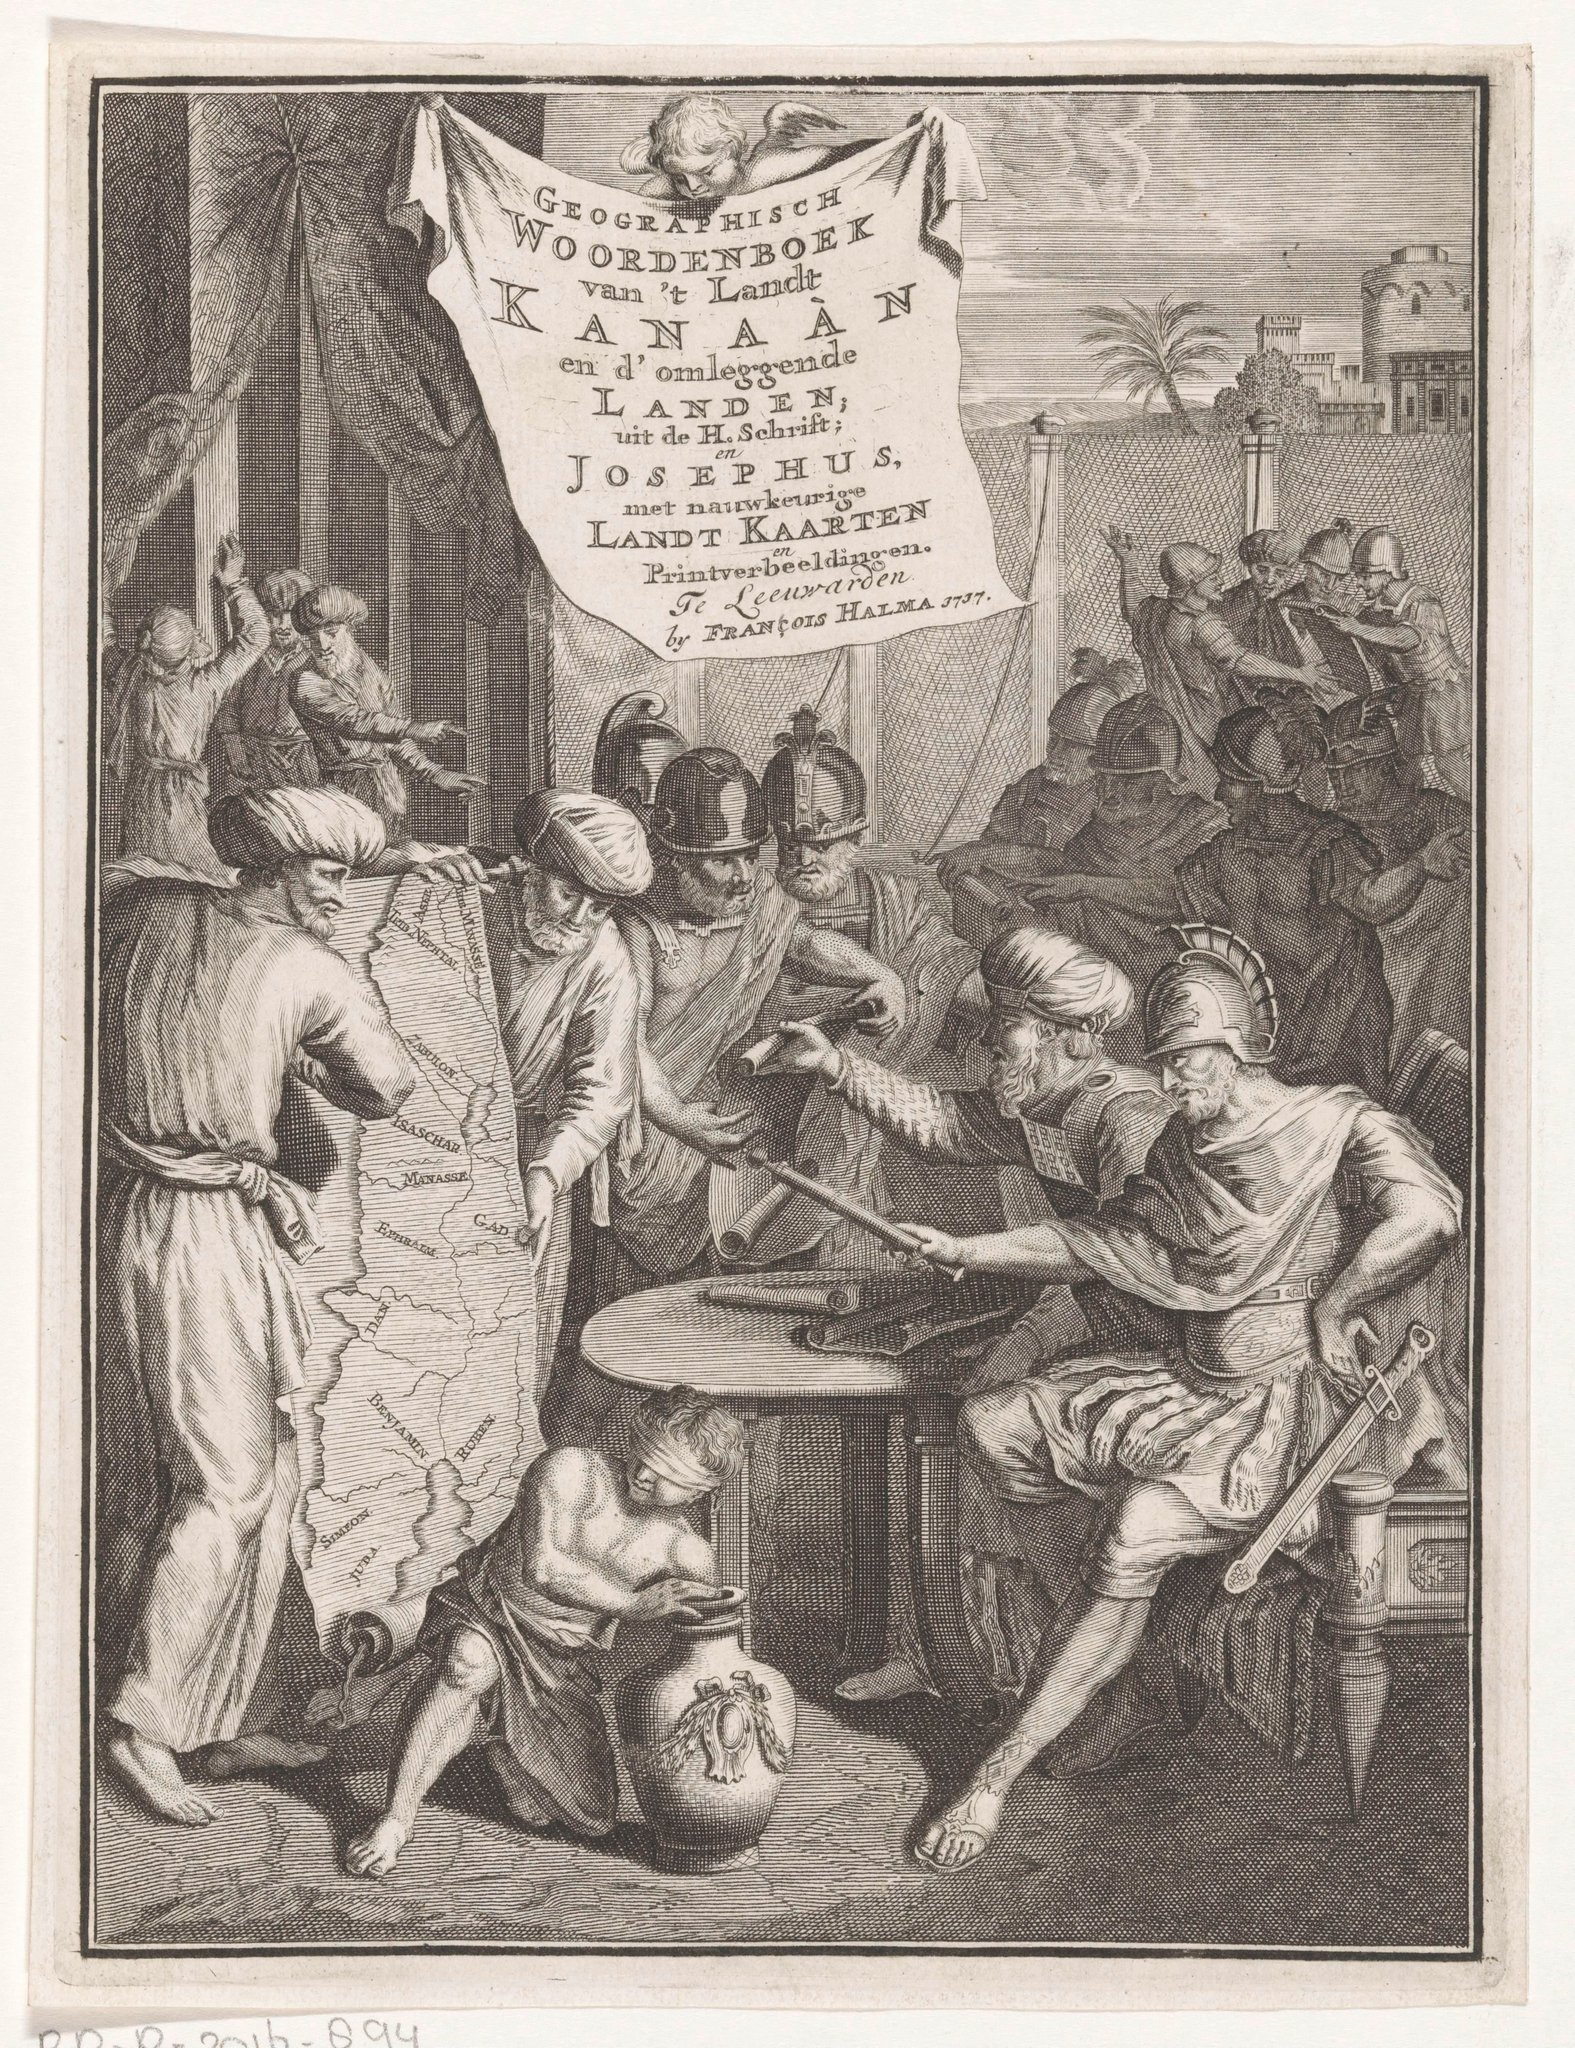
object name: print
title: Mannen bekijken kaart van Kanaän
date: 1717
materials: paper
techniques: engraving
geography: leeuwarden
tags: maps of separate countries or regions, head-gear: turban, the soldier; the soldier's life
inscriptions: collector's mark: Lugt 2228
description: Twee mannen met tulband houden een uitgerolde kaart van het gebied Kanaän vast voor een soldaat en een man met tulband zittend aan een tafel. De twee zittende mannen delen rollen papier uit aan soldaten. Voor hen zit een geblinddoekte putto, zijn arm in een kruik gestoken. In de achtergrond groepen mannen met tulband en soldaten.